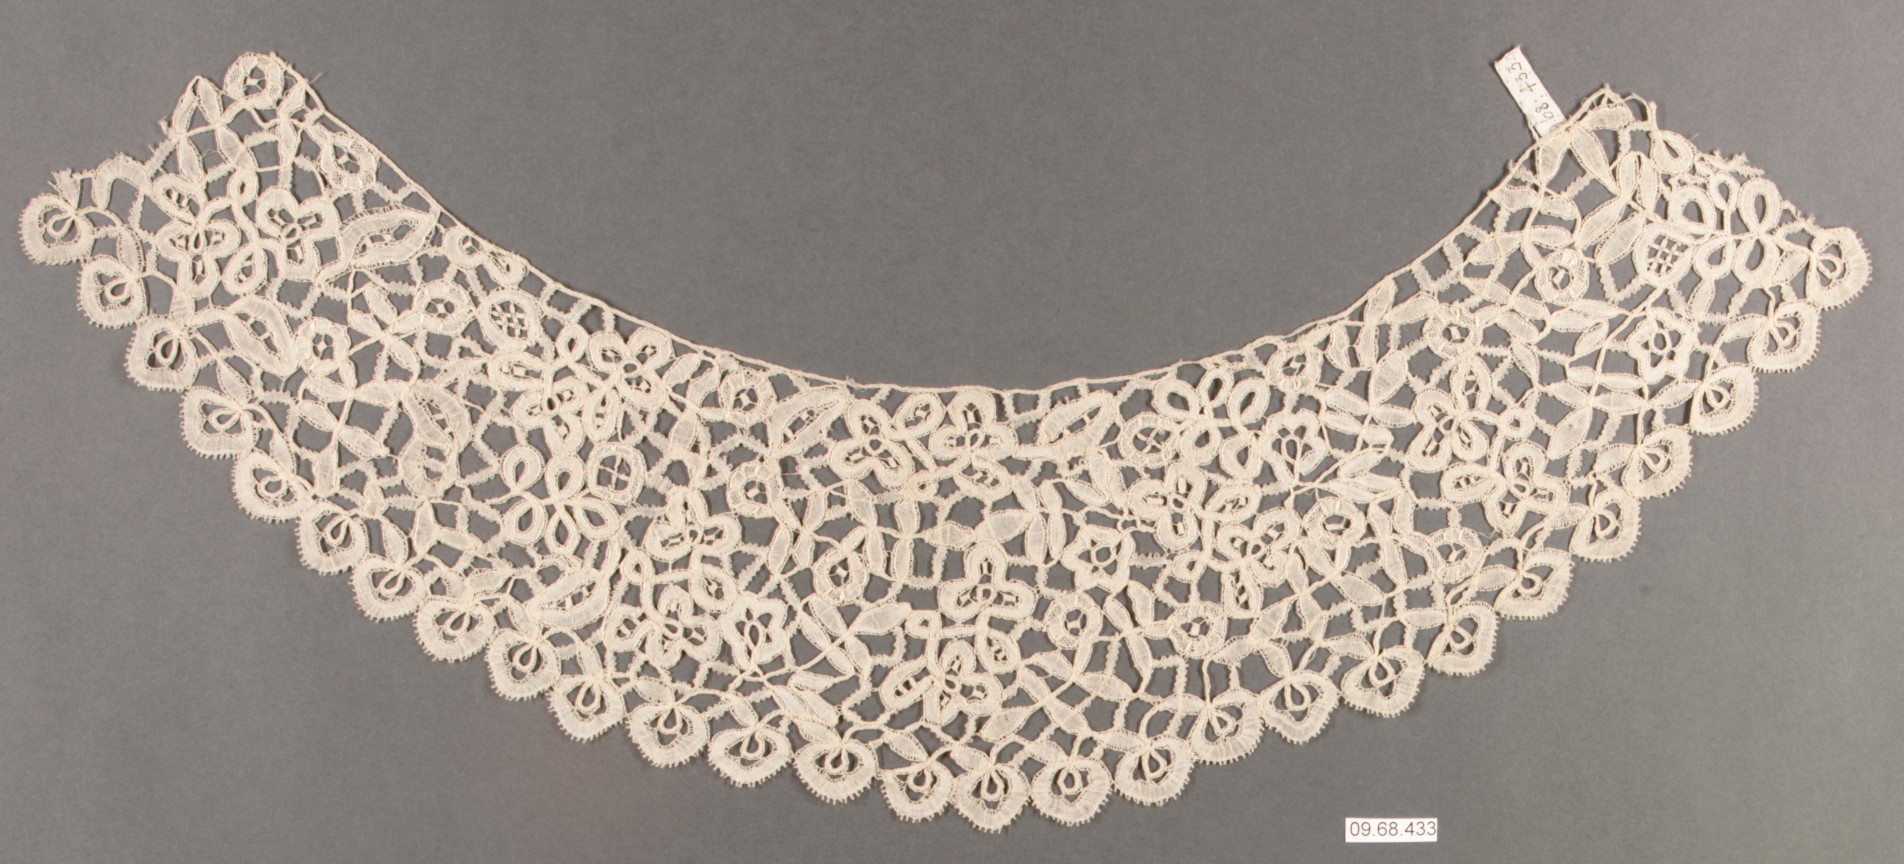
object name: cuff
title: Pair of cuffs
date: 1801-1900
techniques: lace